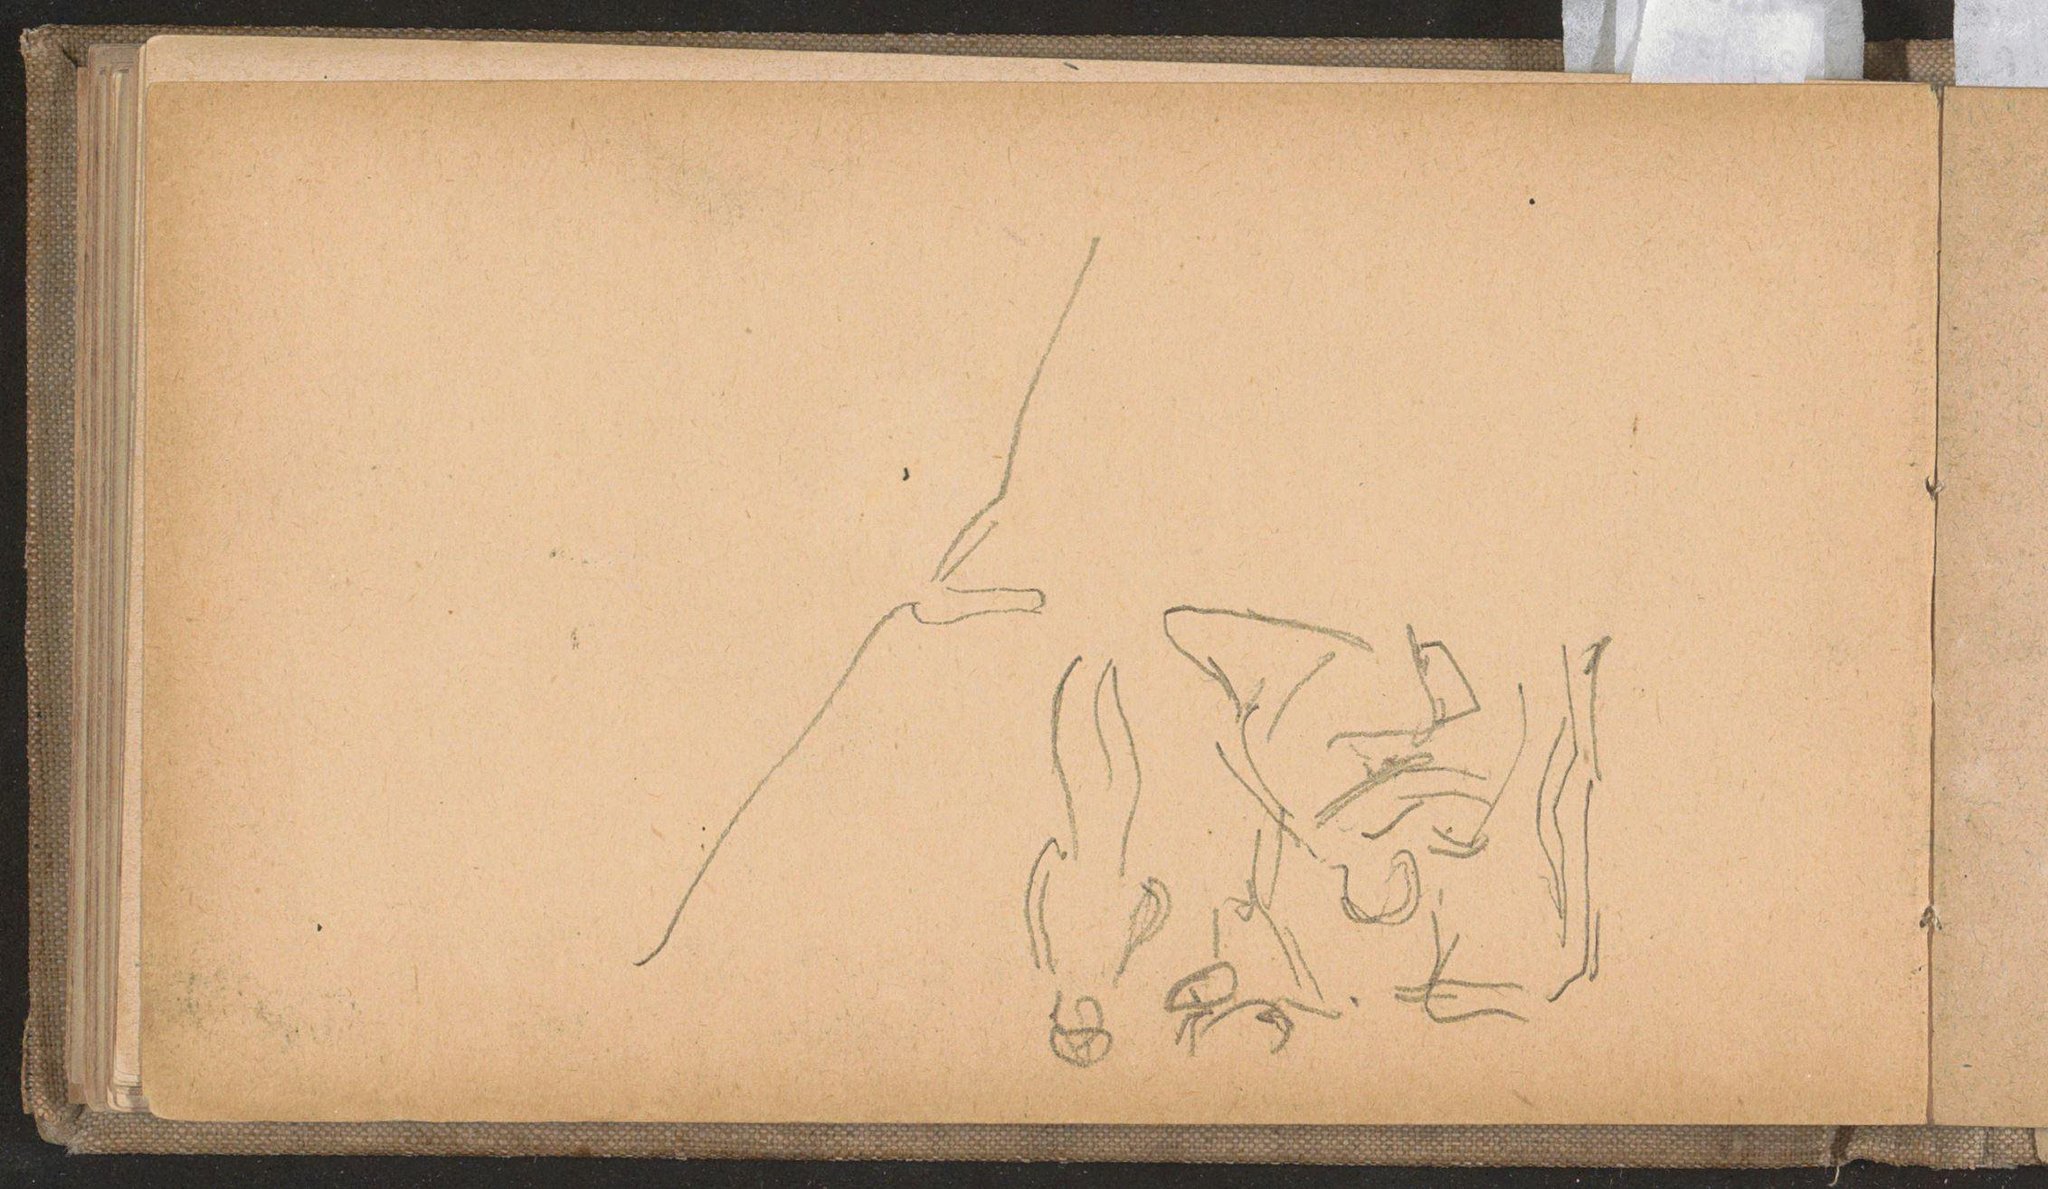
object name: sketchbook leaf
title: Groep staande en knielende figuren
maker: antoon derkinderen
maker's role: draughtsman, painter, print maker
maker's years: 1859-1925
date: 1892-1901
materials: paper, pencil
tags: standing figure, kneeling figure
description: Blad 35 verso uit een schetsboek met 51 bladen.